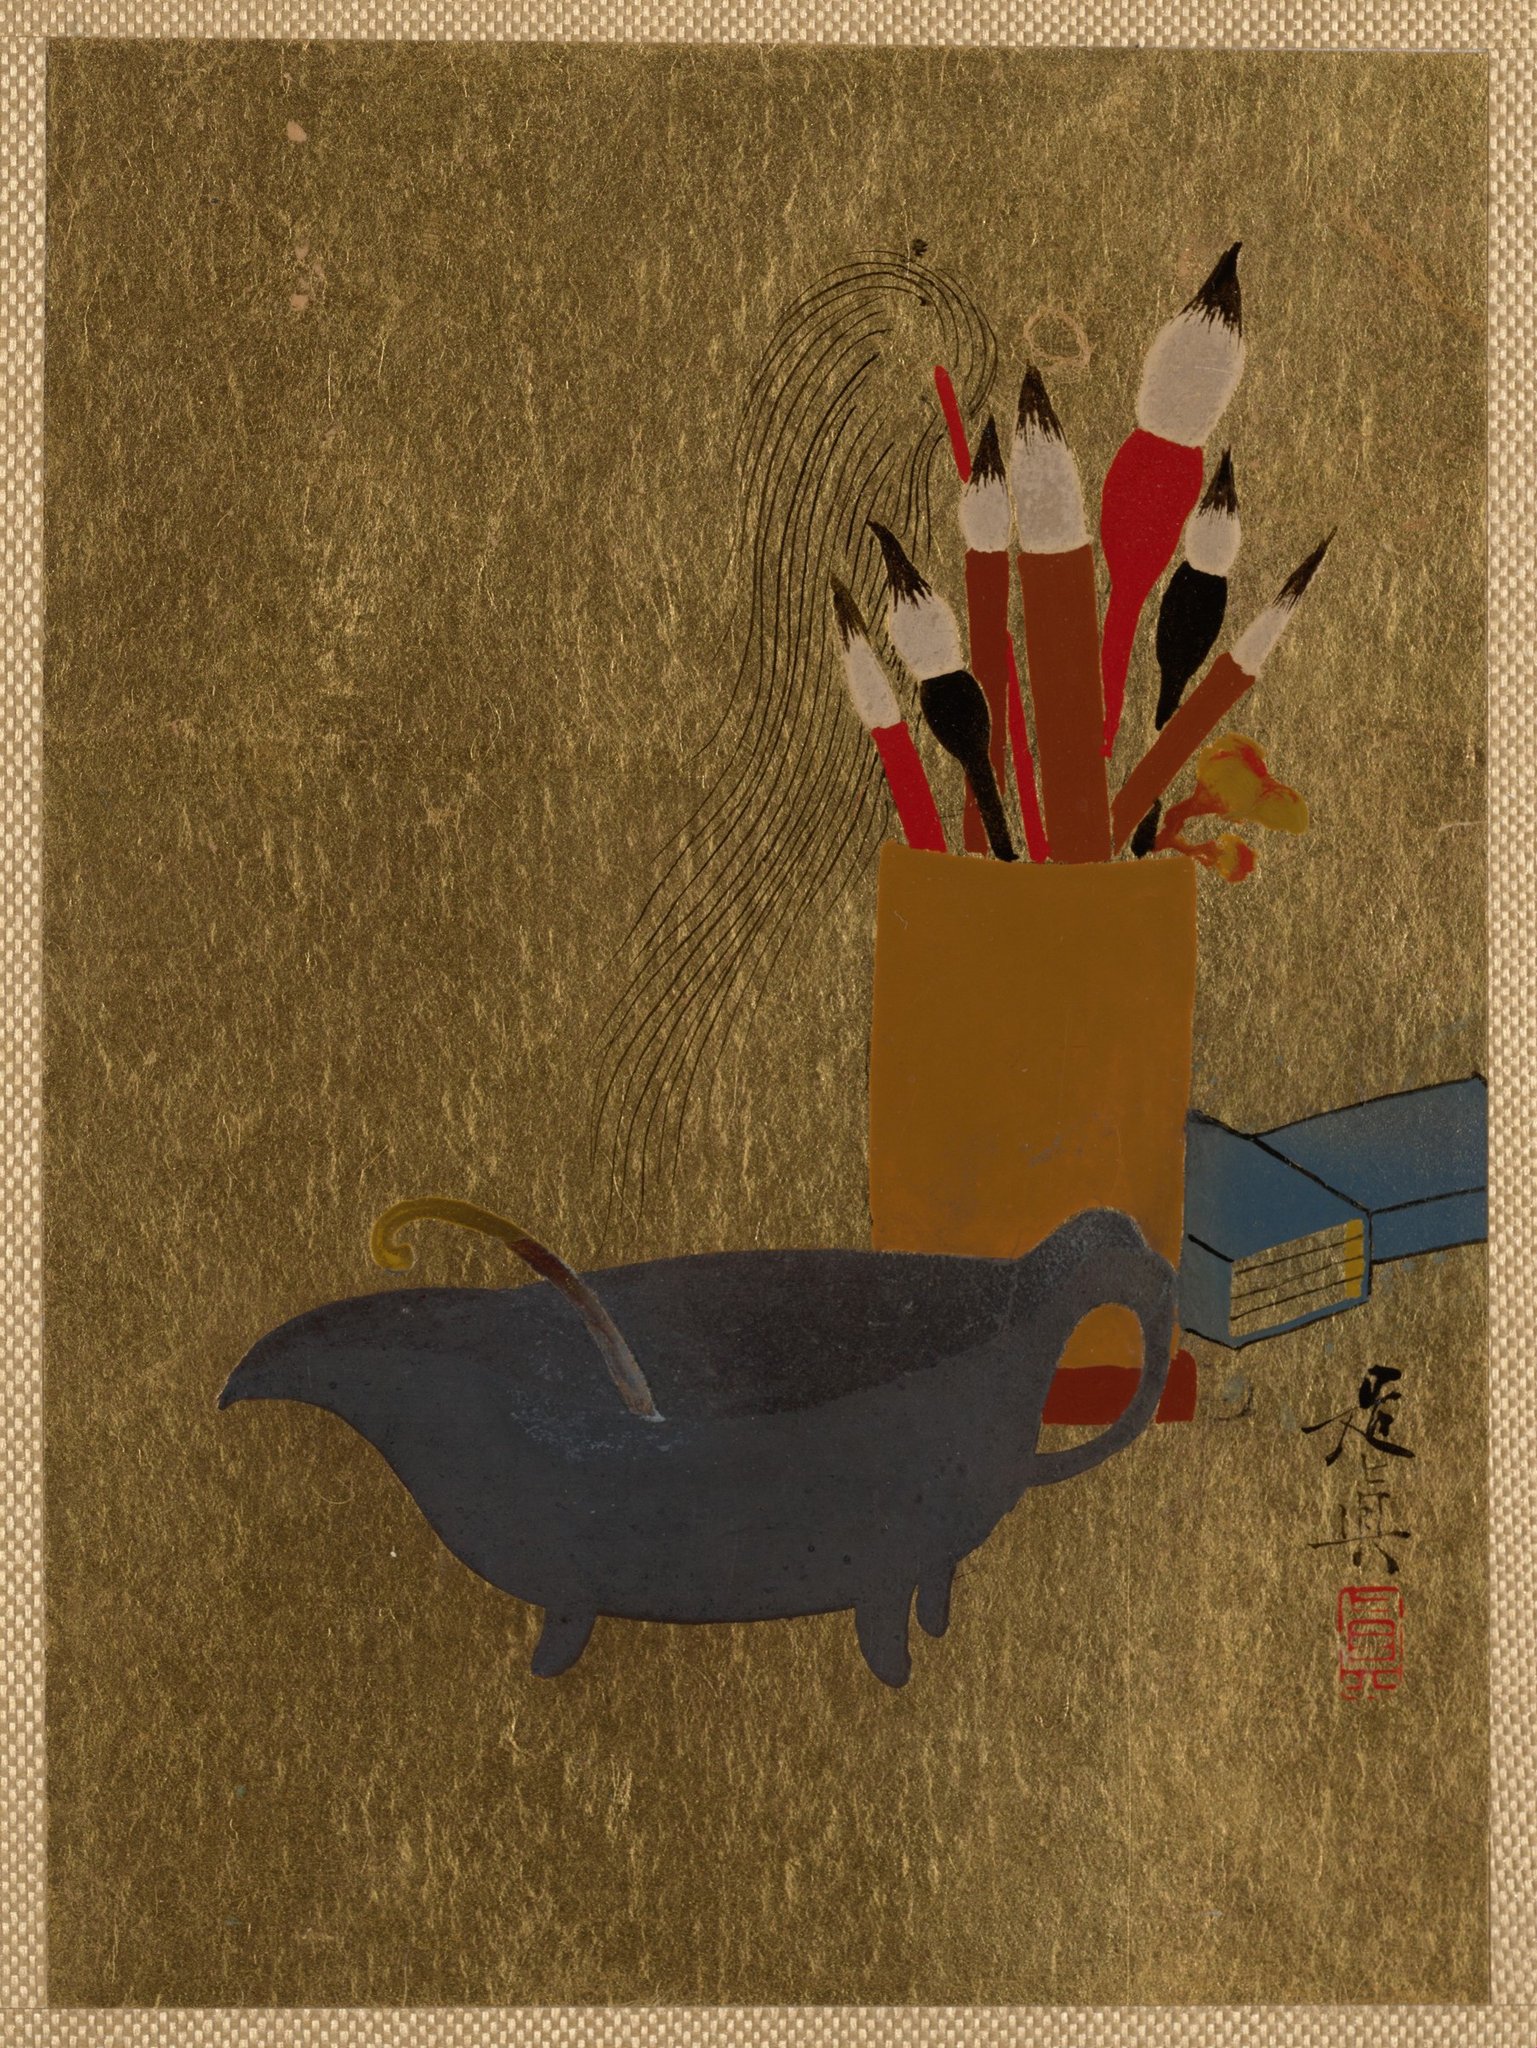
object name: album leaf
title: Kettle and Box with Paint Brushes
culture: japanese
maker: shibata zeshin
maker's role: artist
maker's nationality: japanese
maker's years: 1807-1891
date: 1882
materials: gold, lacquer, paper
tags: kettles,brushes